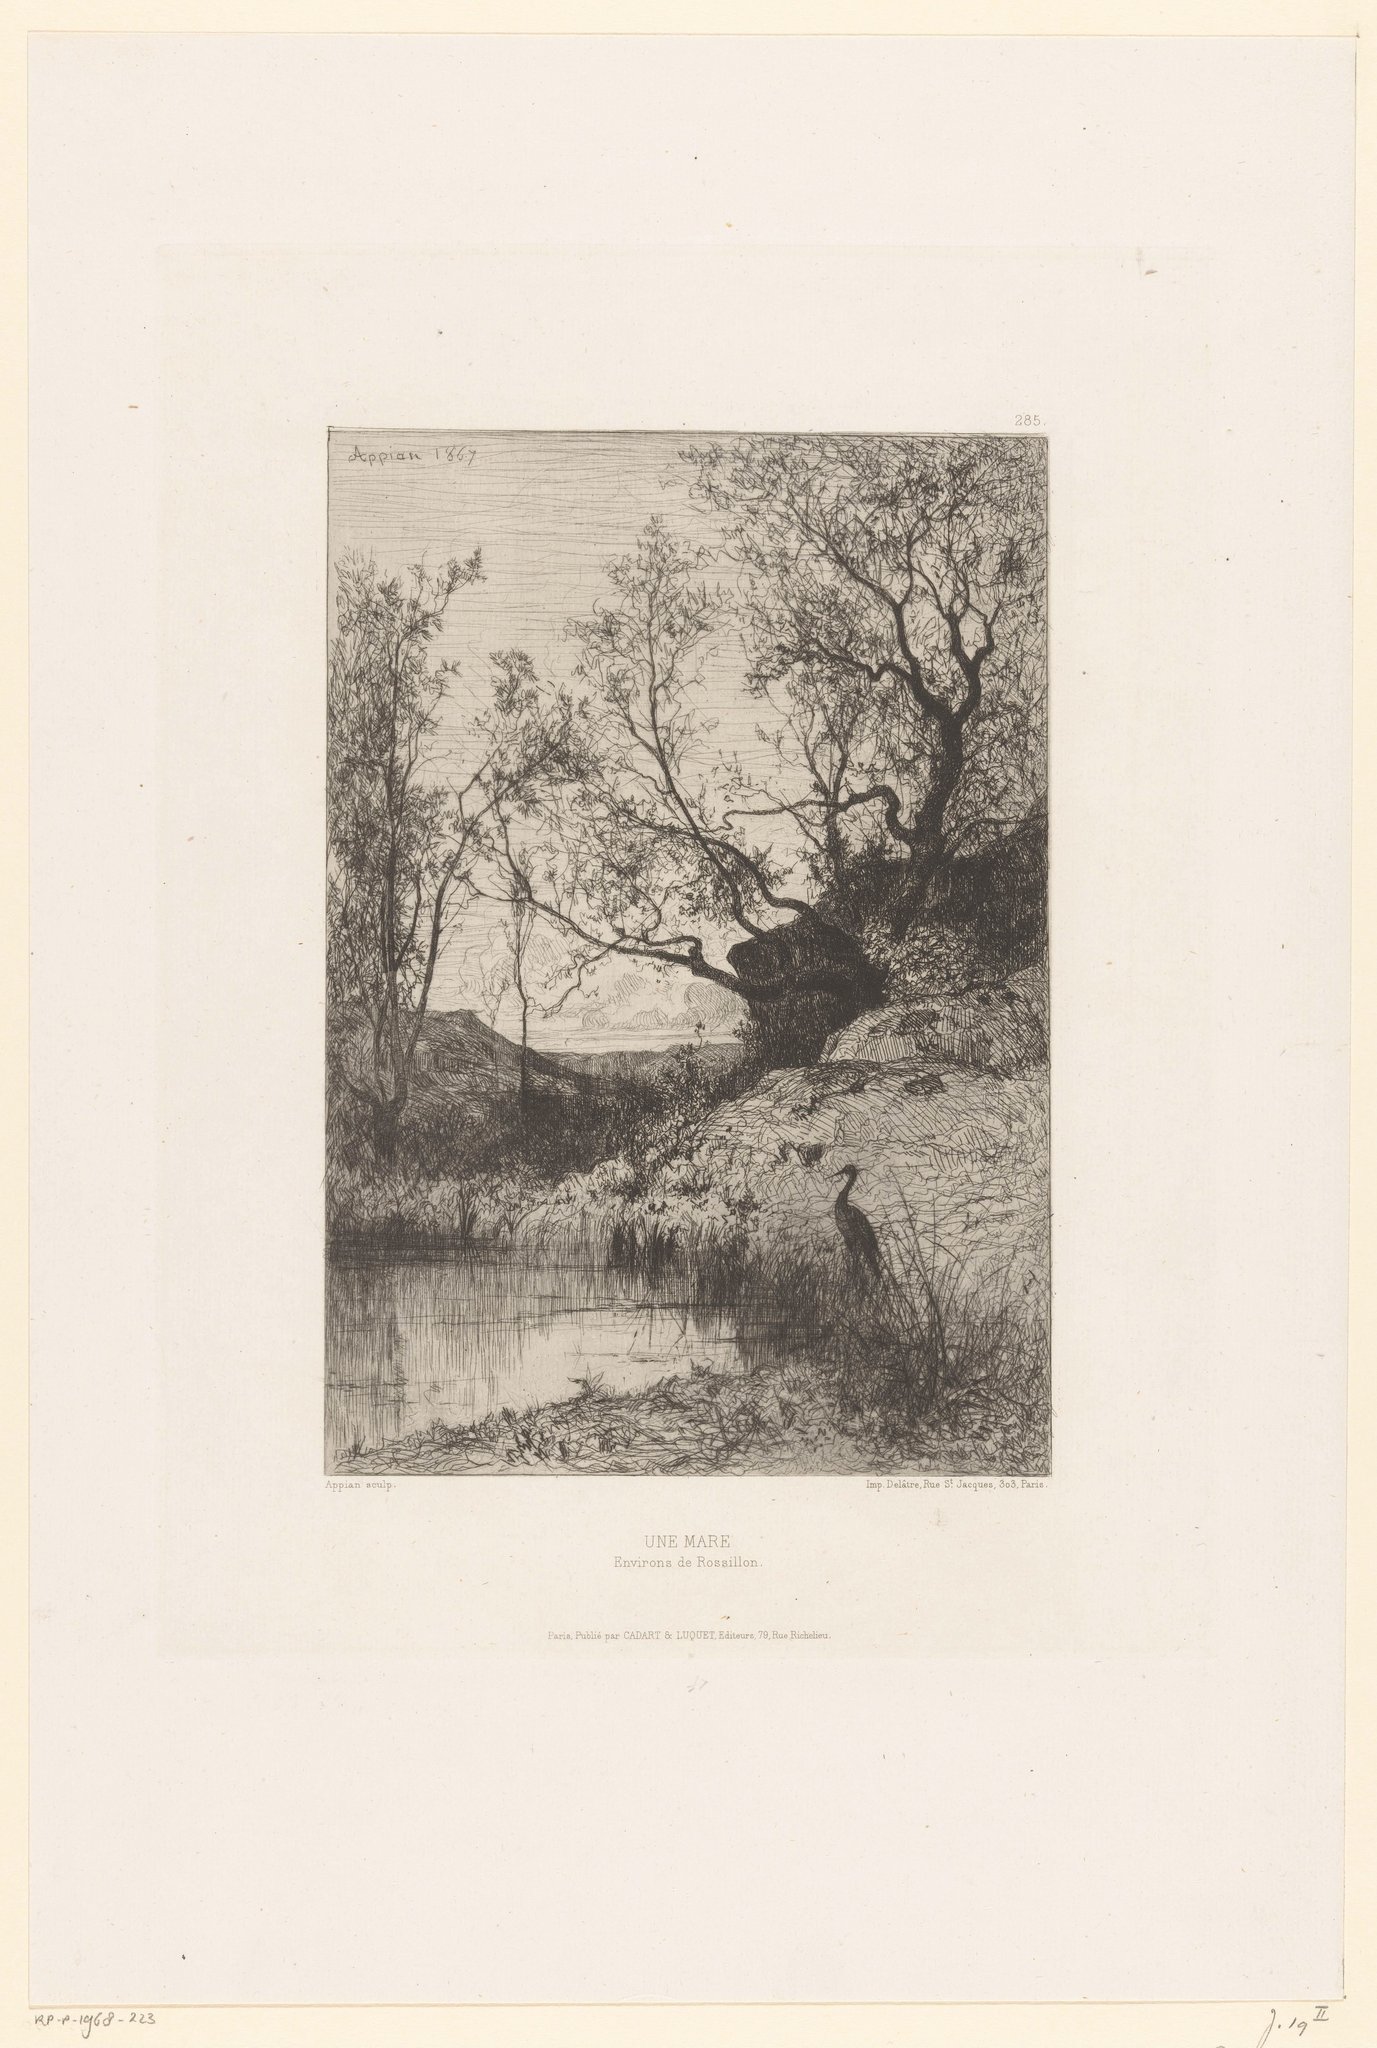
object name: print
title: Reiger aan de oever van een vijver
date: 1867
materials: paper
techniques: etching, intaglio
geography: paris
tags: trees, shore-birds and wading-birds: heron, pool, puddle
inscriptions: collector's mark: Lugt 2228, collector's mark: Lugt 2760